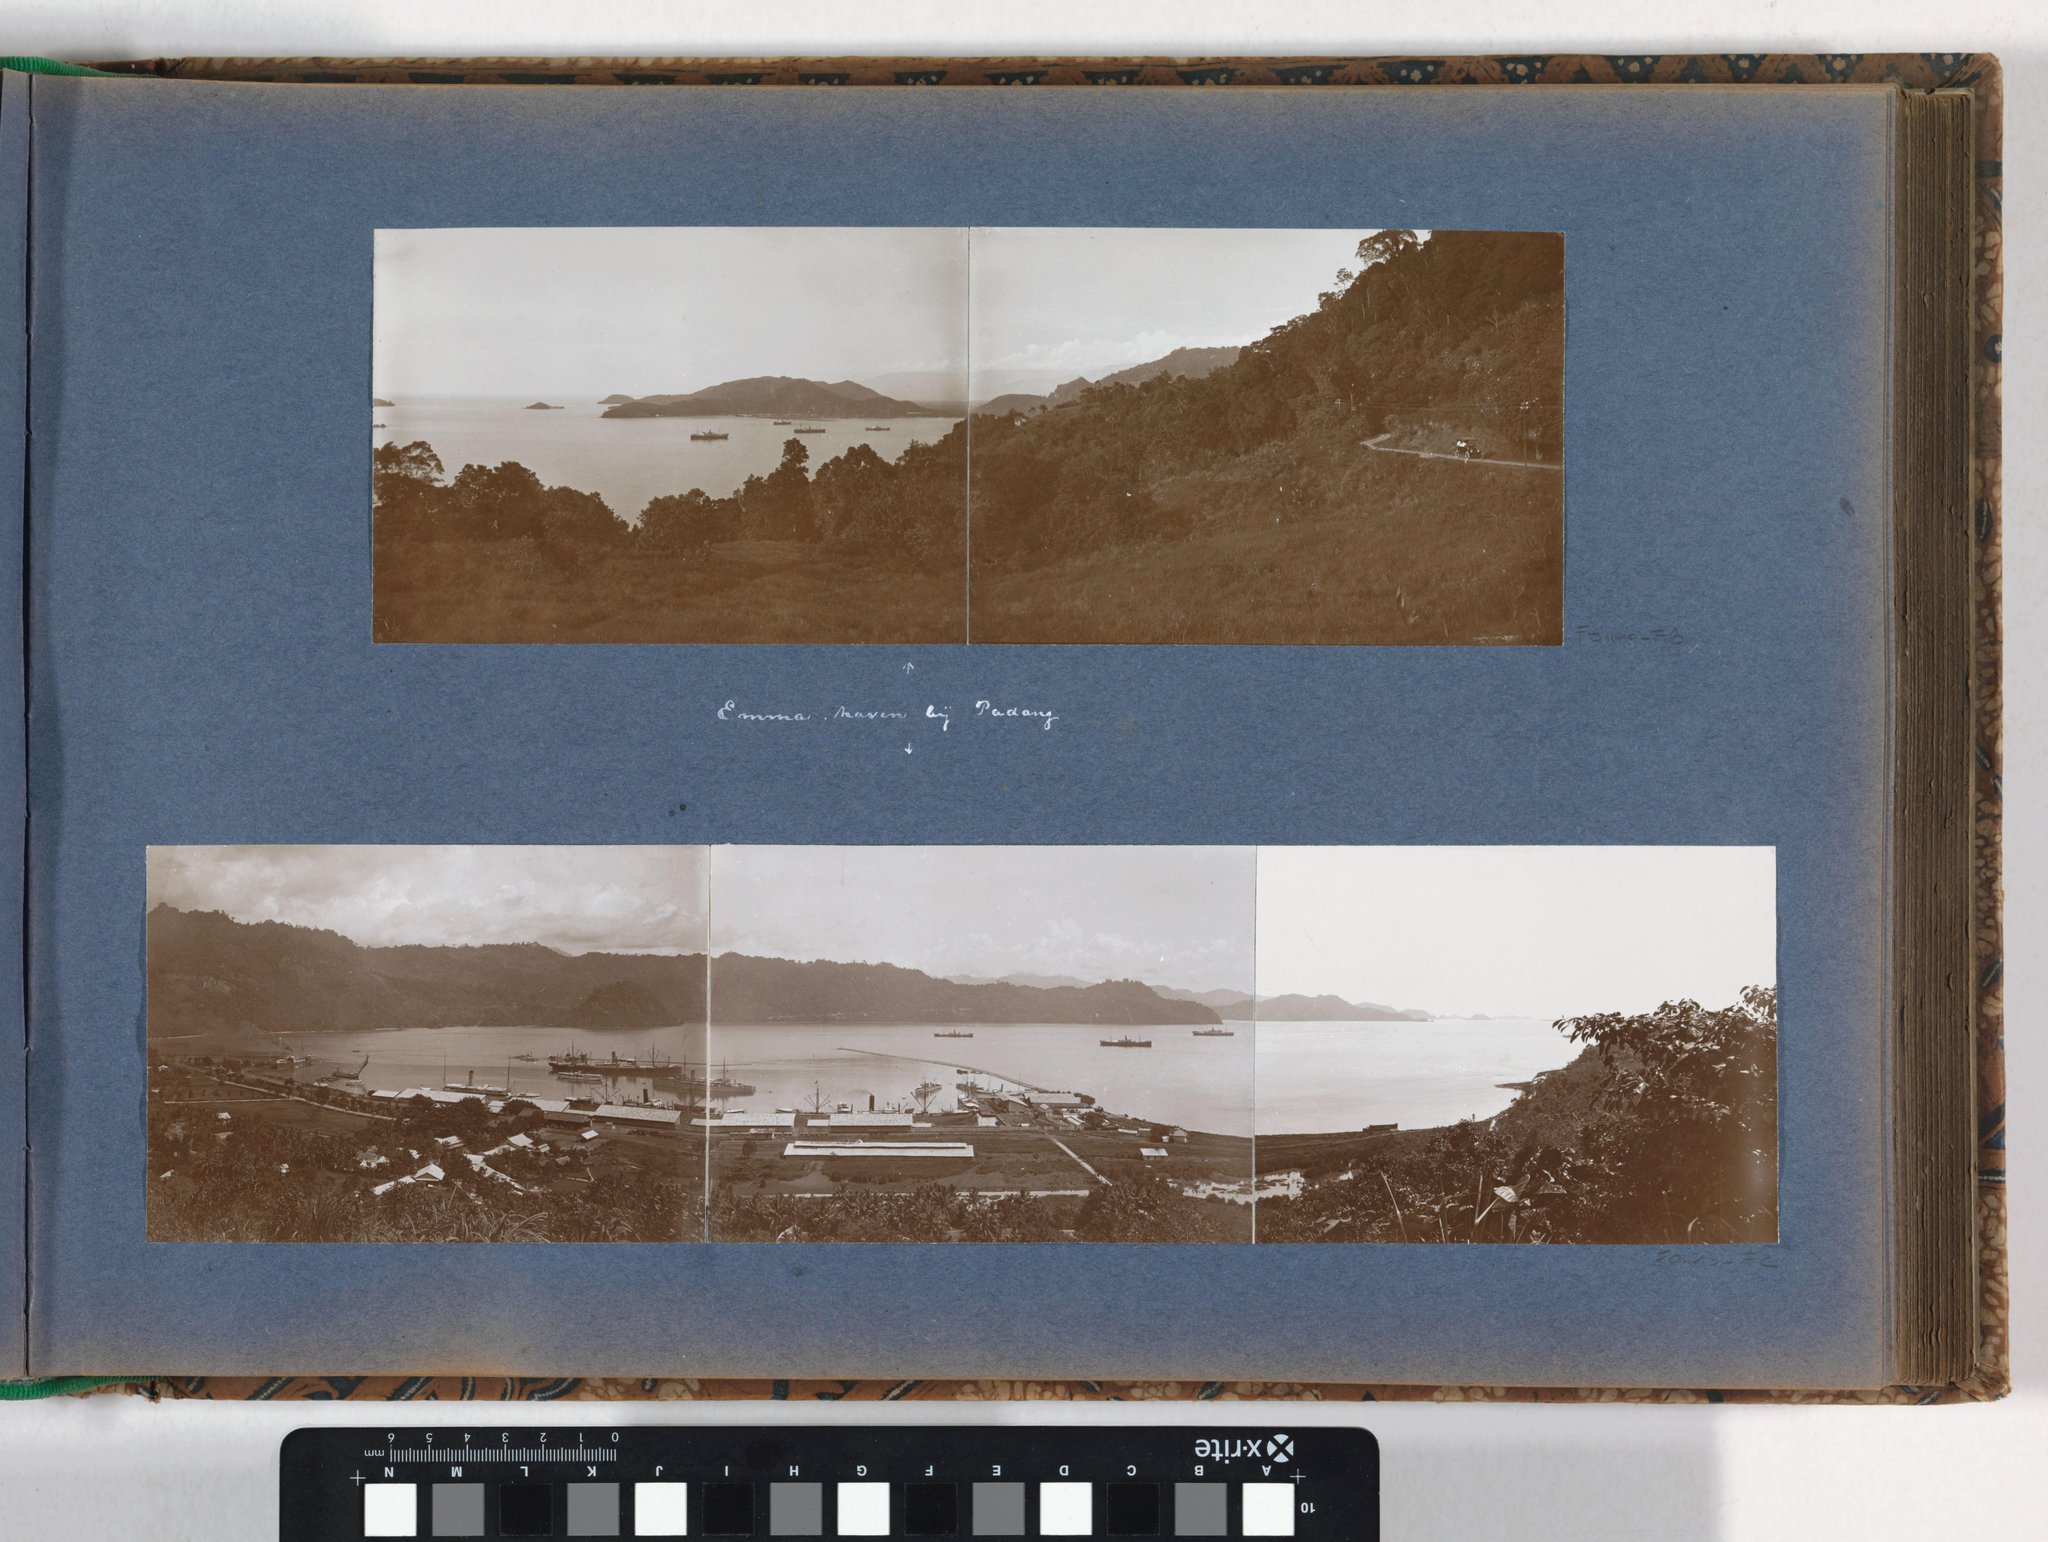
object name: album leaf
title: Gezicht op de Emmahaven in Padang met schepen, loodsen, pier en spoorweg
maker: Anonymous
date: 1900-1920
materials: paper, photographic support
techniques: gelatin silver print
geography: padang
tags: warehouse (~ harbour), harbour (+ view ~ vehicle, ship, etc.), railway, train, pier, quay, wharf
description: Panoramafoto bestaande uit drie afdrukken.